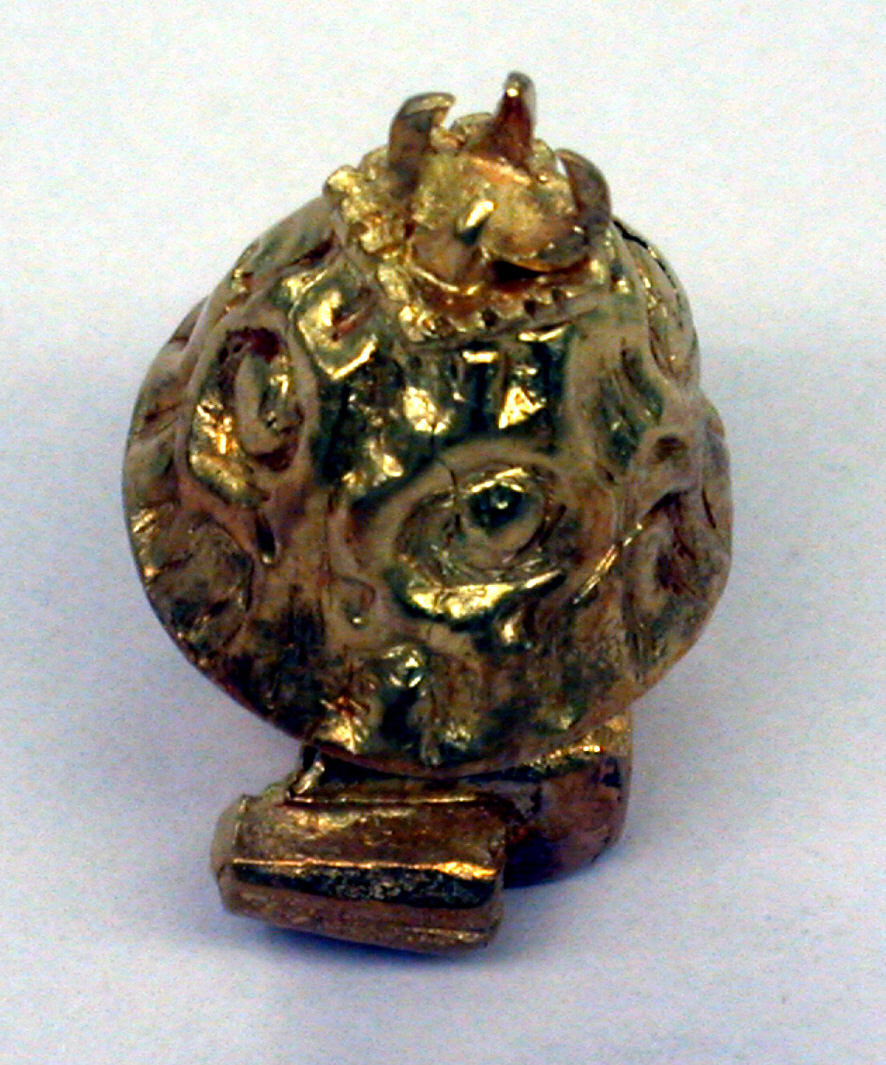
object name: ring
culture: mindanao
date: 1301-1500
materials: gold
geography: philippines